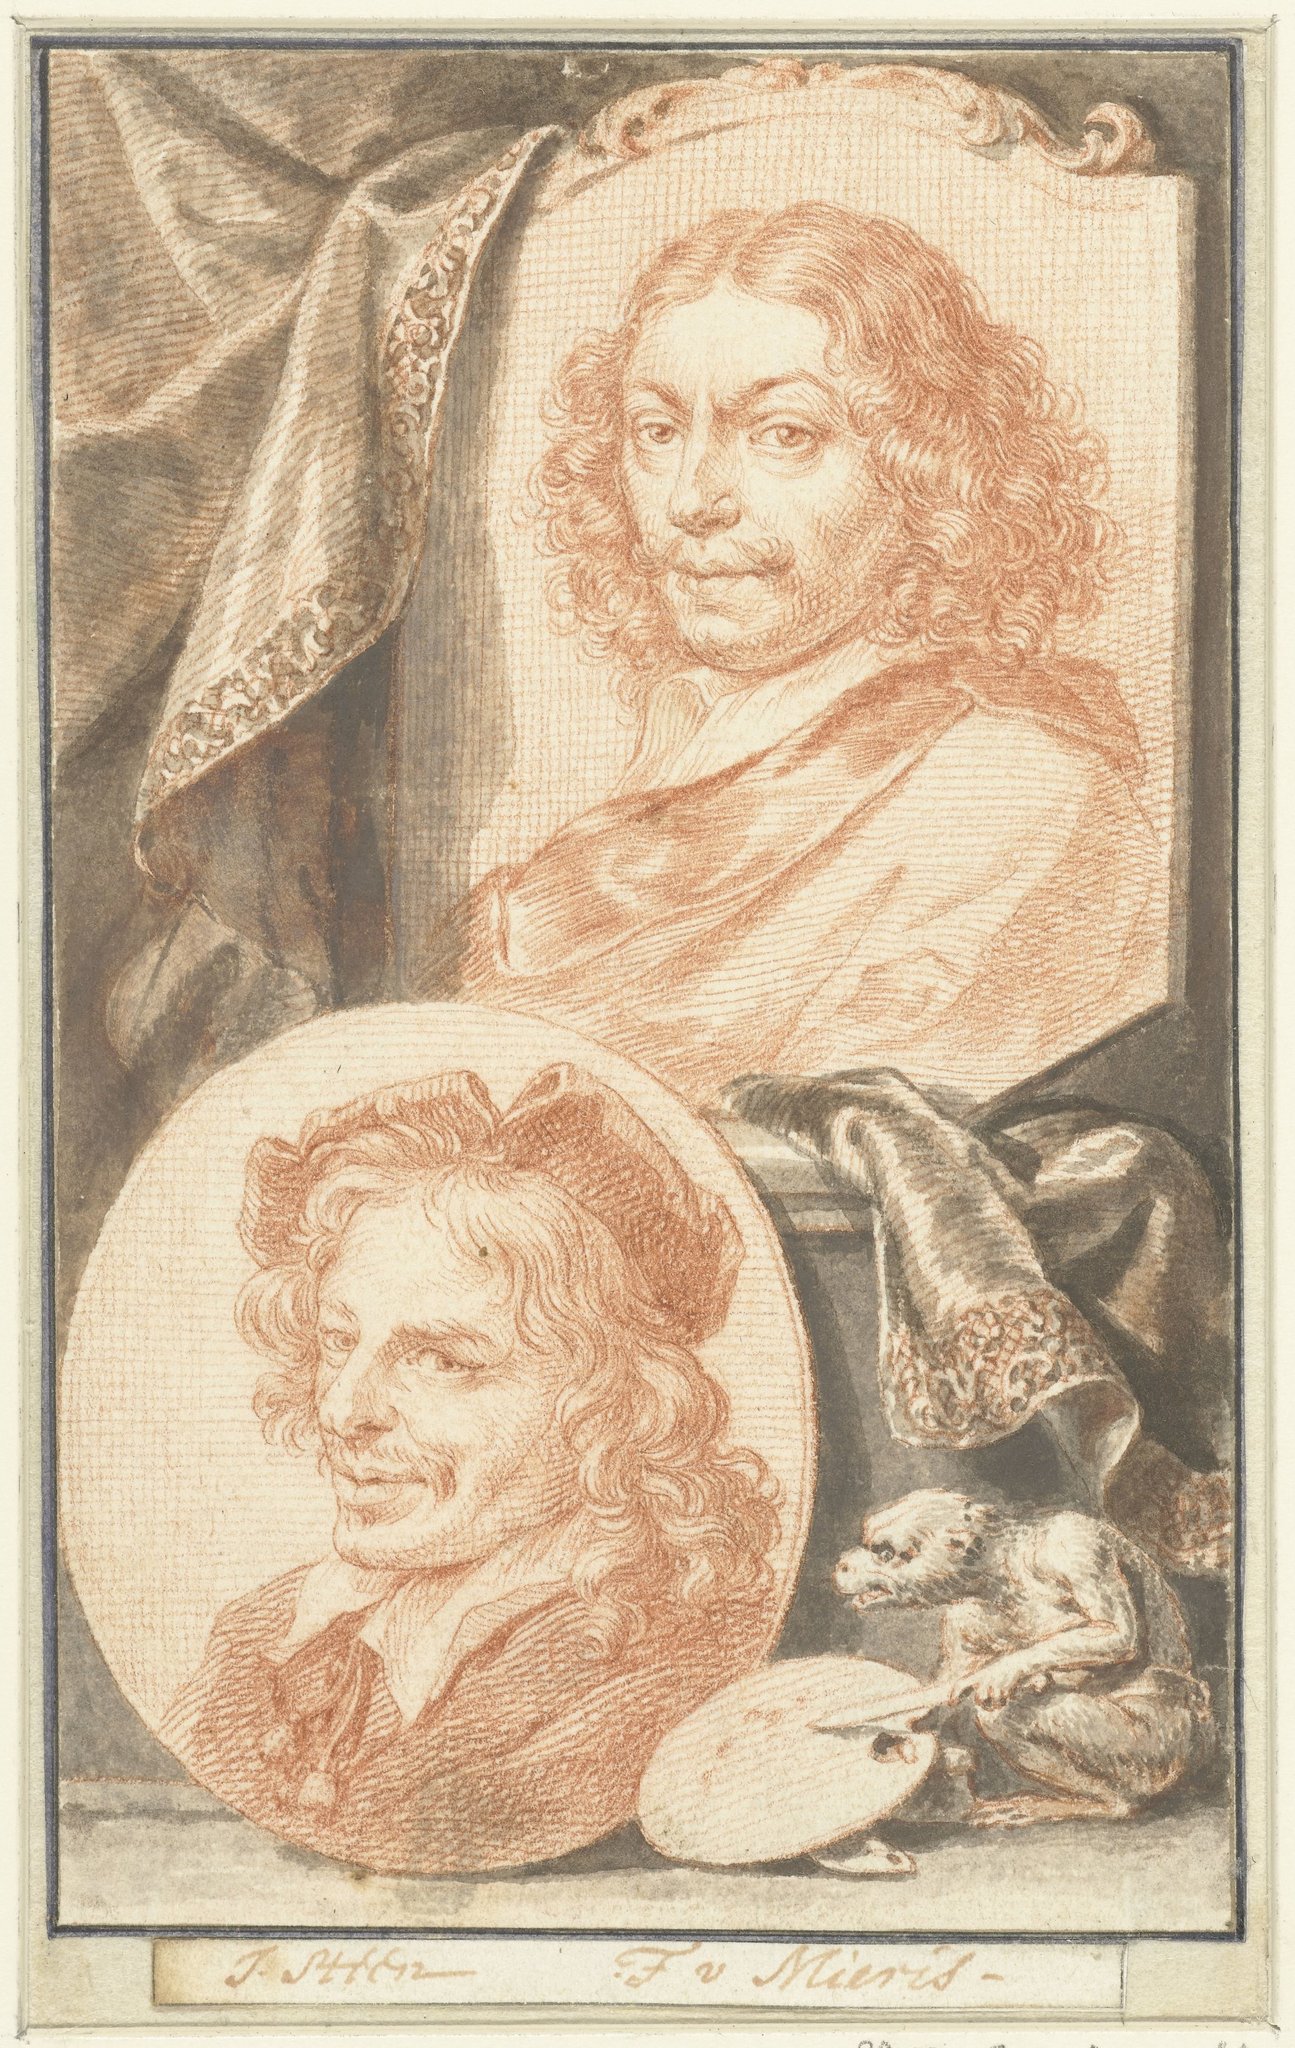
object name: design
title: Portretten van Jan Steen en Frans van Mieris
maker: jacob houbraken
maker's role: draughtsman, print maker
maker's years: 1698-1780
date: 1708-1780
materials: chalk, paper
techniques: brush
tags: leiden, painter, print maker, jan havicksz. steen, frans van mieris (i), historical persons, portrait, self-portrait of painter, portrait, self-portrait of artist